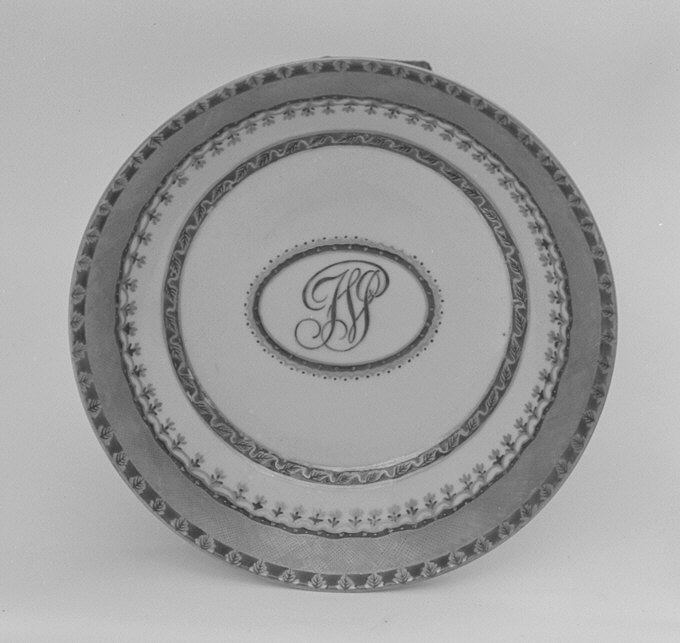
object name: saucer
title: Saucer (part of a service)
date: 1785-1800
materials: hard paste porcelain